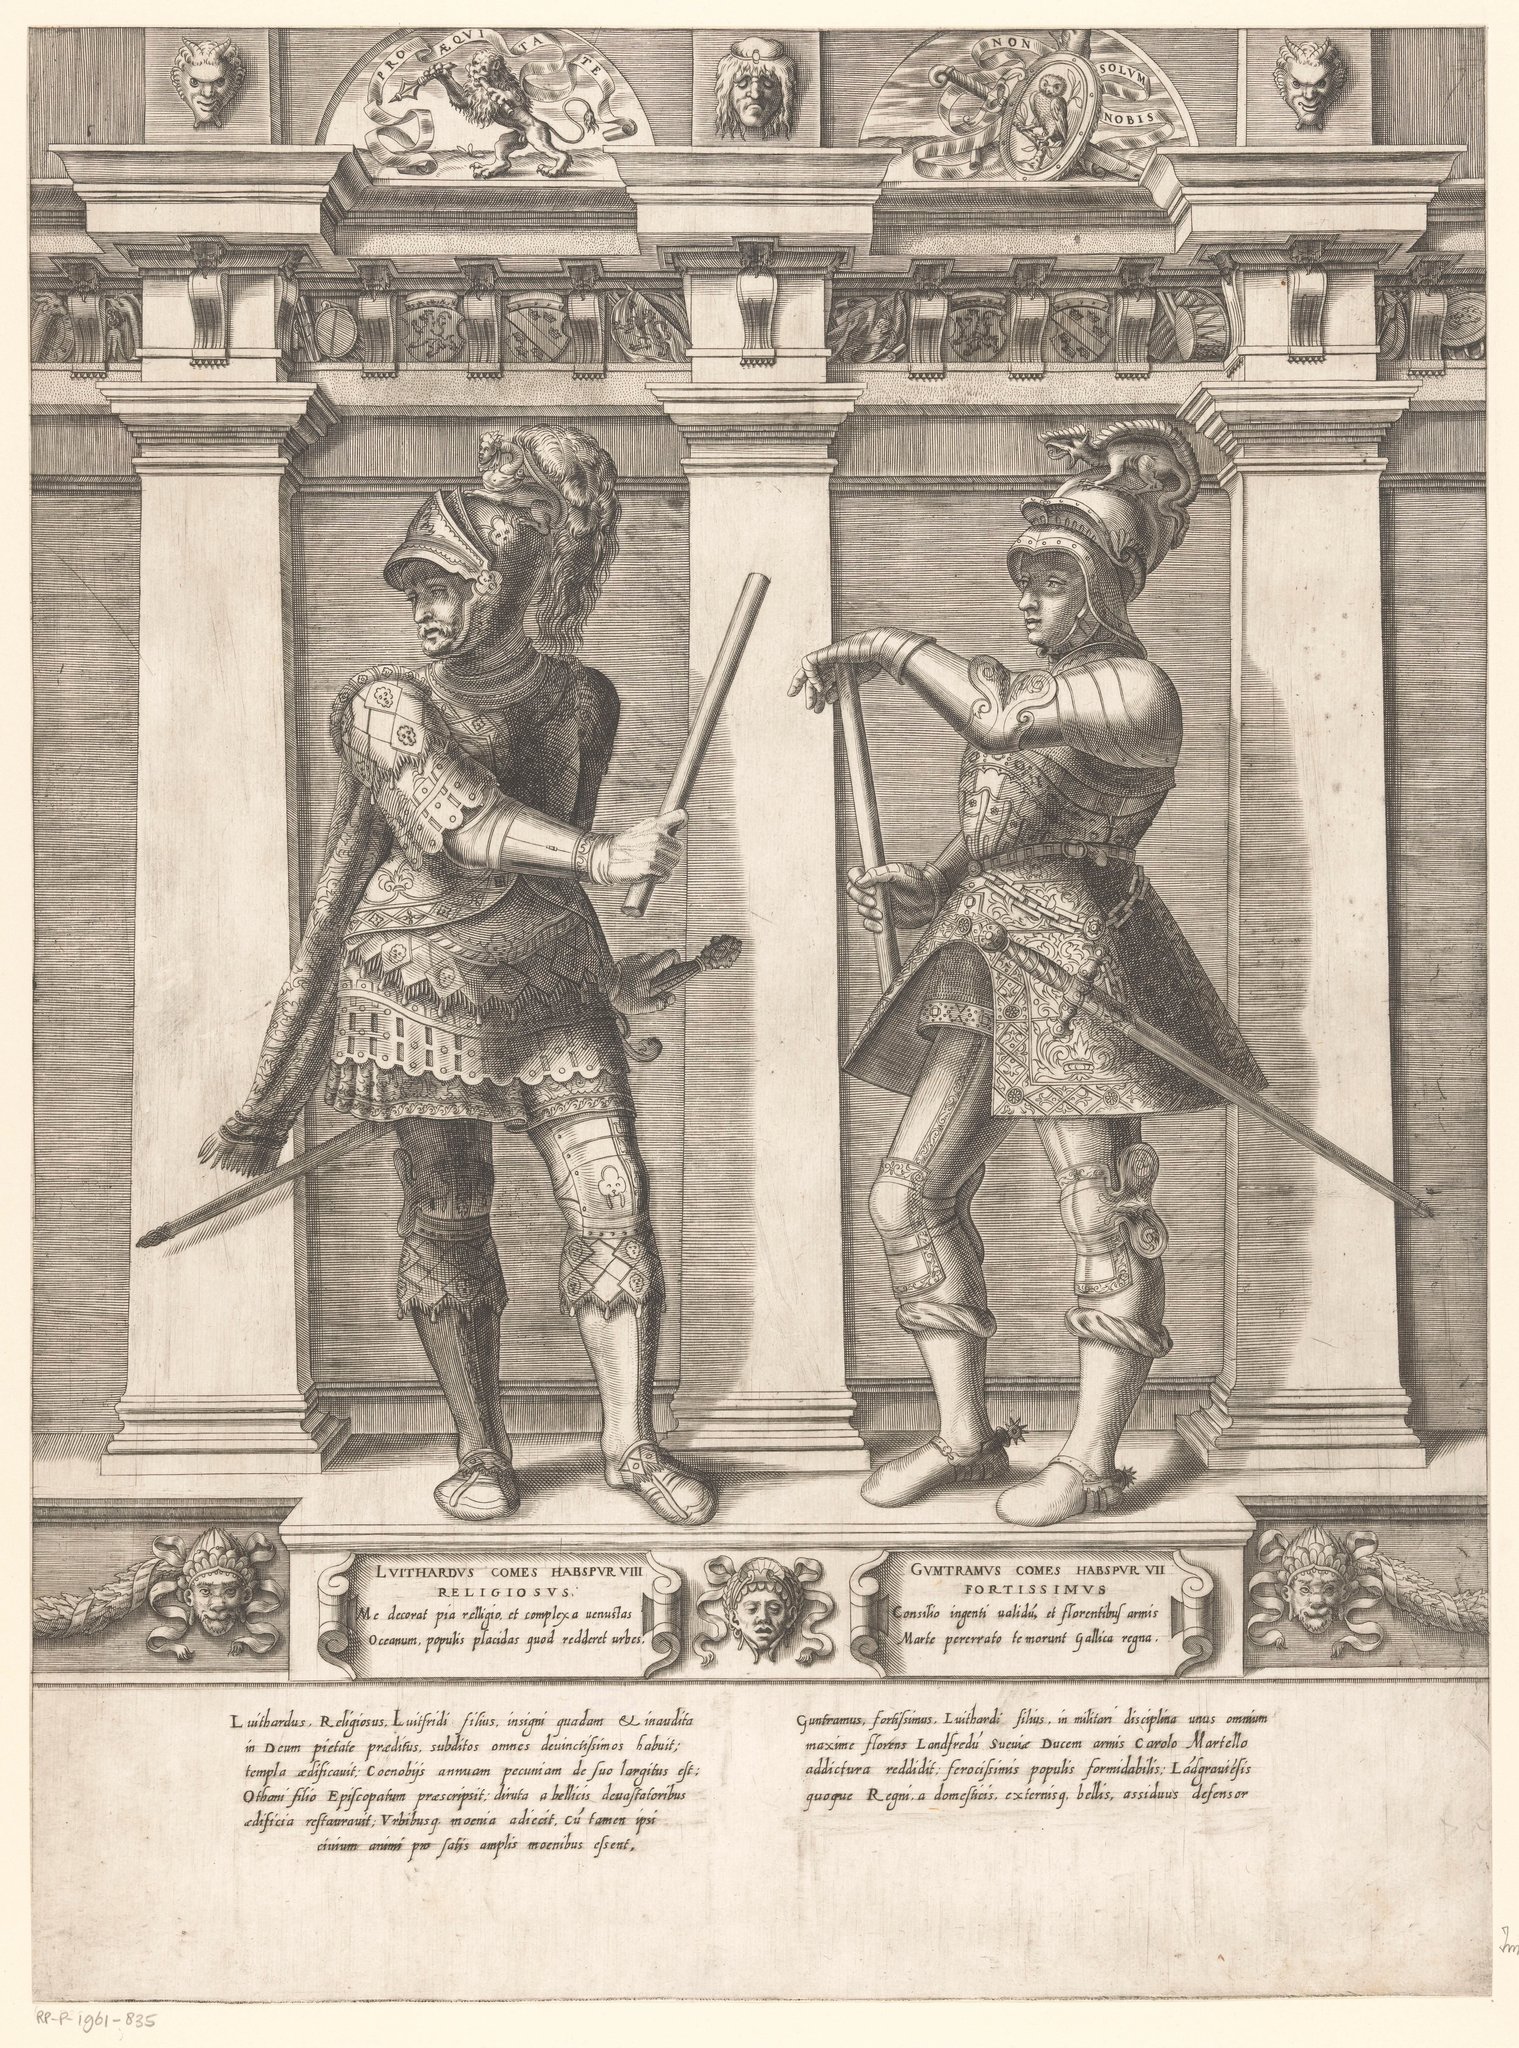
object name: print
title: Dubbelportret van Luitardus en Guntramus van Habsburg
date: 1569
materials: paper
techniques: engraving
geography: italy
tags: historical persons, ruler, sovereign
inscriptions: collector's mark: Lugt 2228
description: Deze prent maakt deel uit van een reeks van 58 prenten. Het meerendeel van de prenten bevat portretten van 74 leden van het Oostenrijkse Huis, naar tekeningen door Francesco Terzio, die deels getekend zijn naar de 28 levensgrote bronzen beelden die rond de cenotaaf van Maximiliaan I in de Hofkirche te Innsbruck staan.